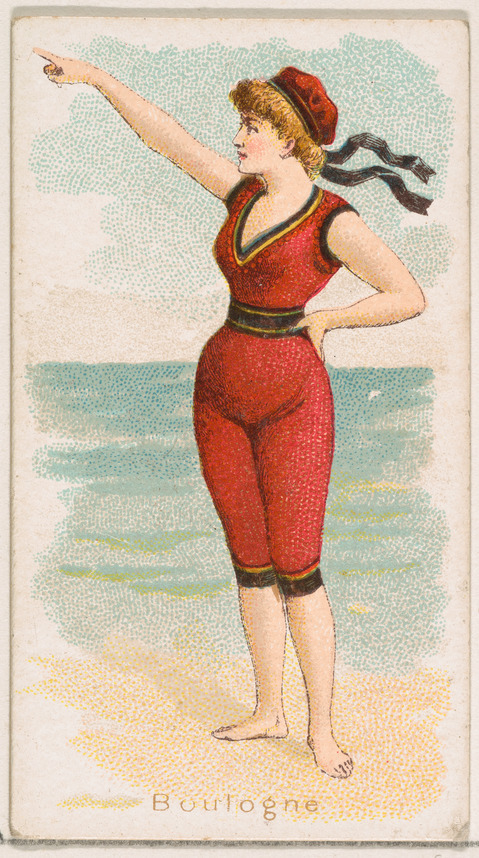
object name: print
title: Boulogne, from the Fancy Bathers series (N187) issued by Wm. S. Kimball & Co.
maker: william s. kimball & company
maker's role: publisher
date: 1889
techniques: color lithograph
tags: profiles,women